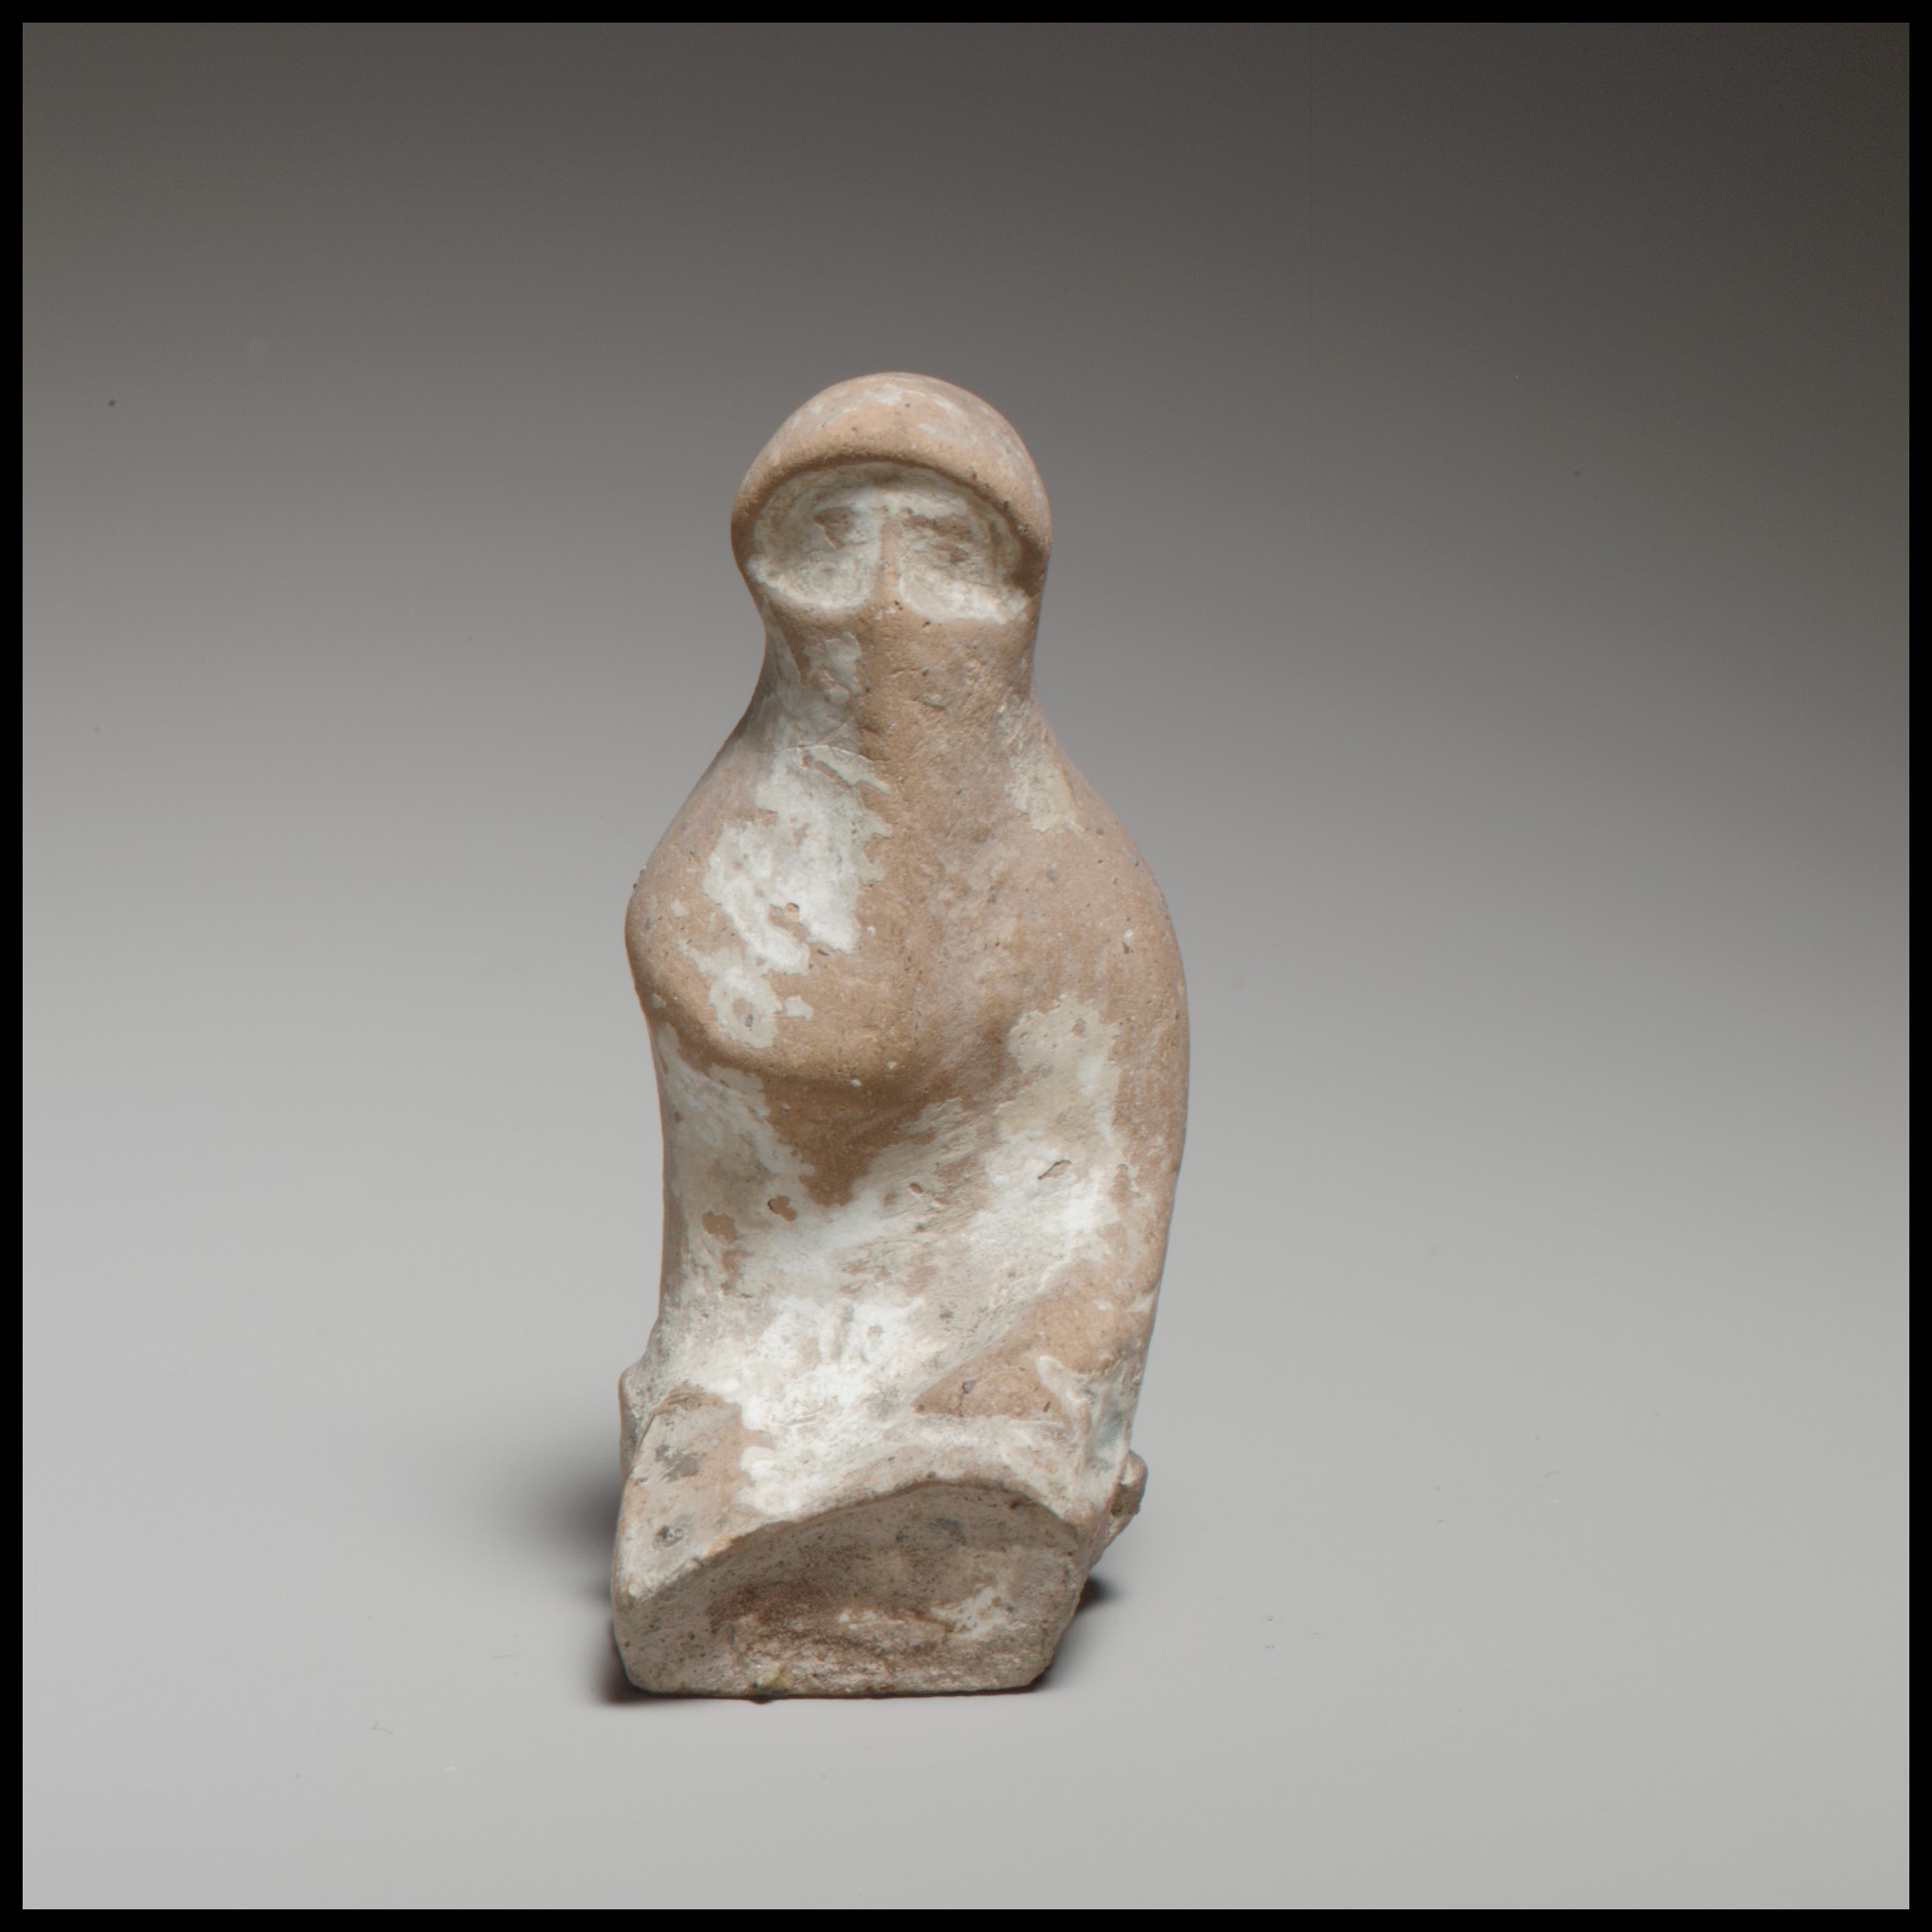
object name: statuette of a woman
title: Terracotta seated veiled woman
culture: cypriot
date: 300-201 BCE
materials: terracotta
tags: women